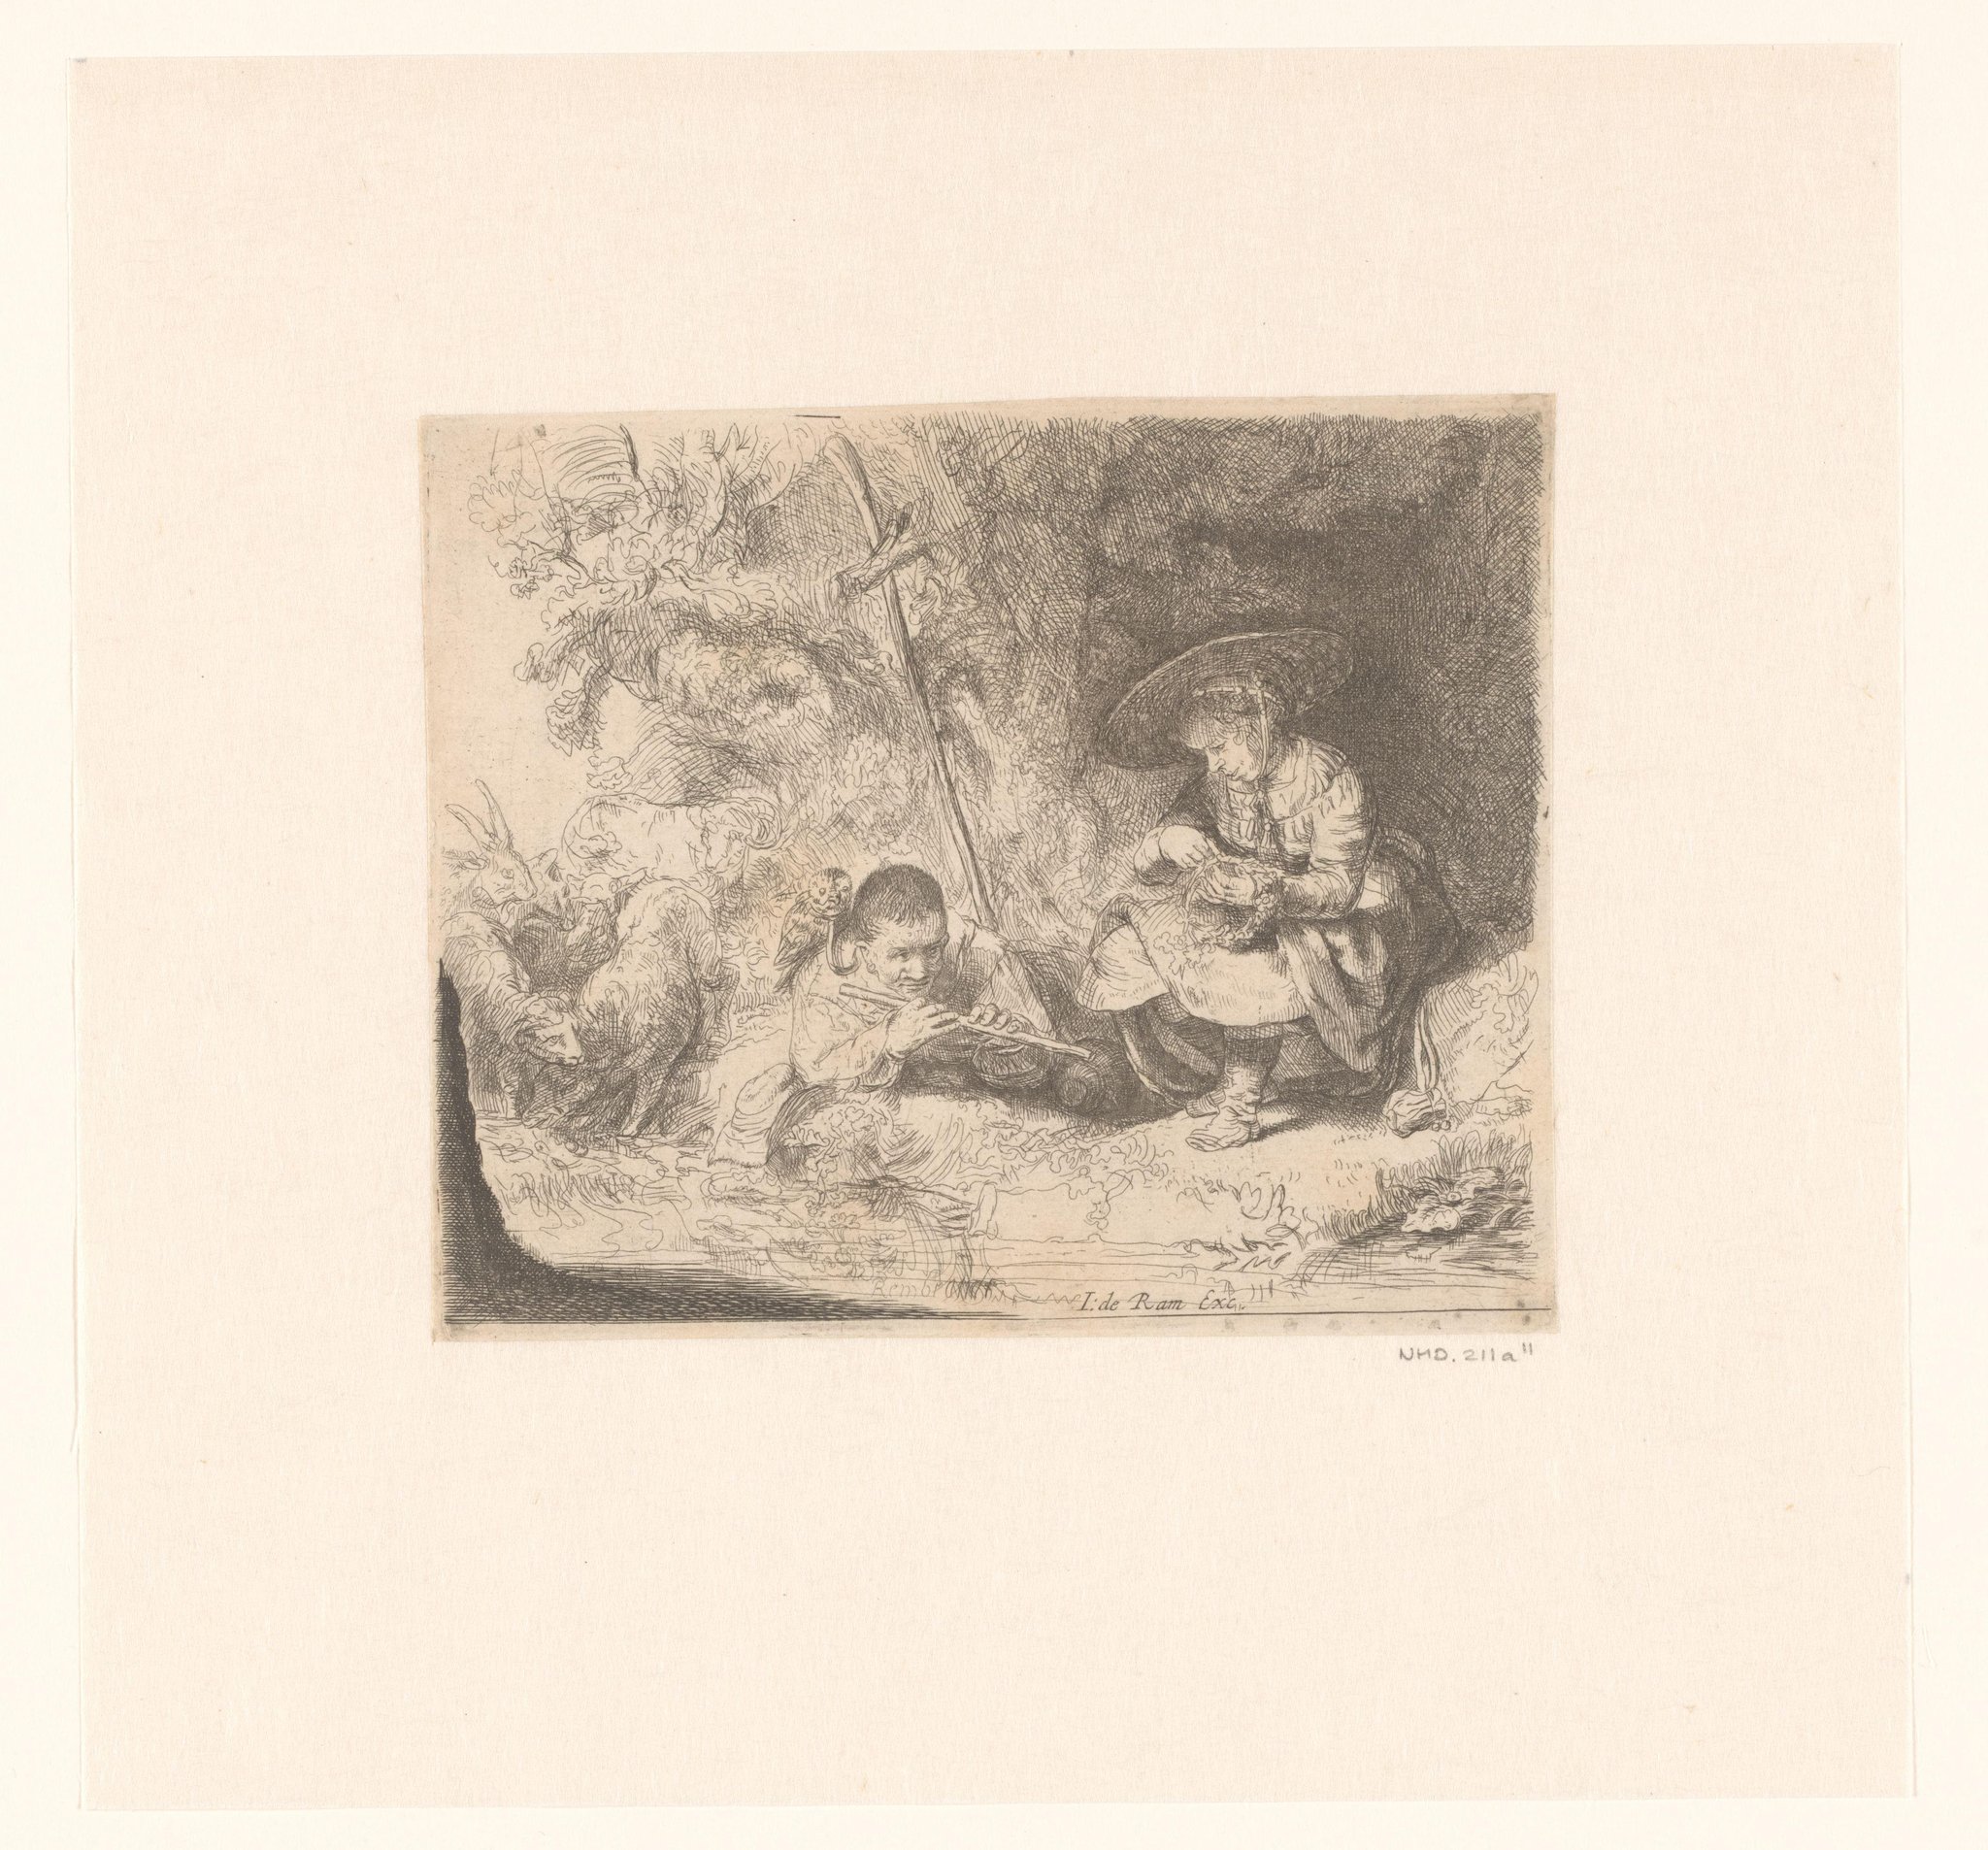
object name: print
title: The flute player ('Het Uilenspiegeltje')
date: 1658-1693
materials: paper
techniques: etching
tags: flute, aulos, tibia - cc - out of doors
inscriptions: collector's mark: Lugt 2228, stamp, collector's mark: Lugt 2760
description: Spiegelbeeldige kopie naar de gelijknamige prent van Rembrandt.